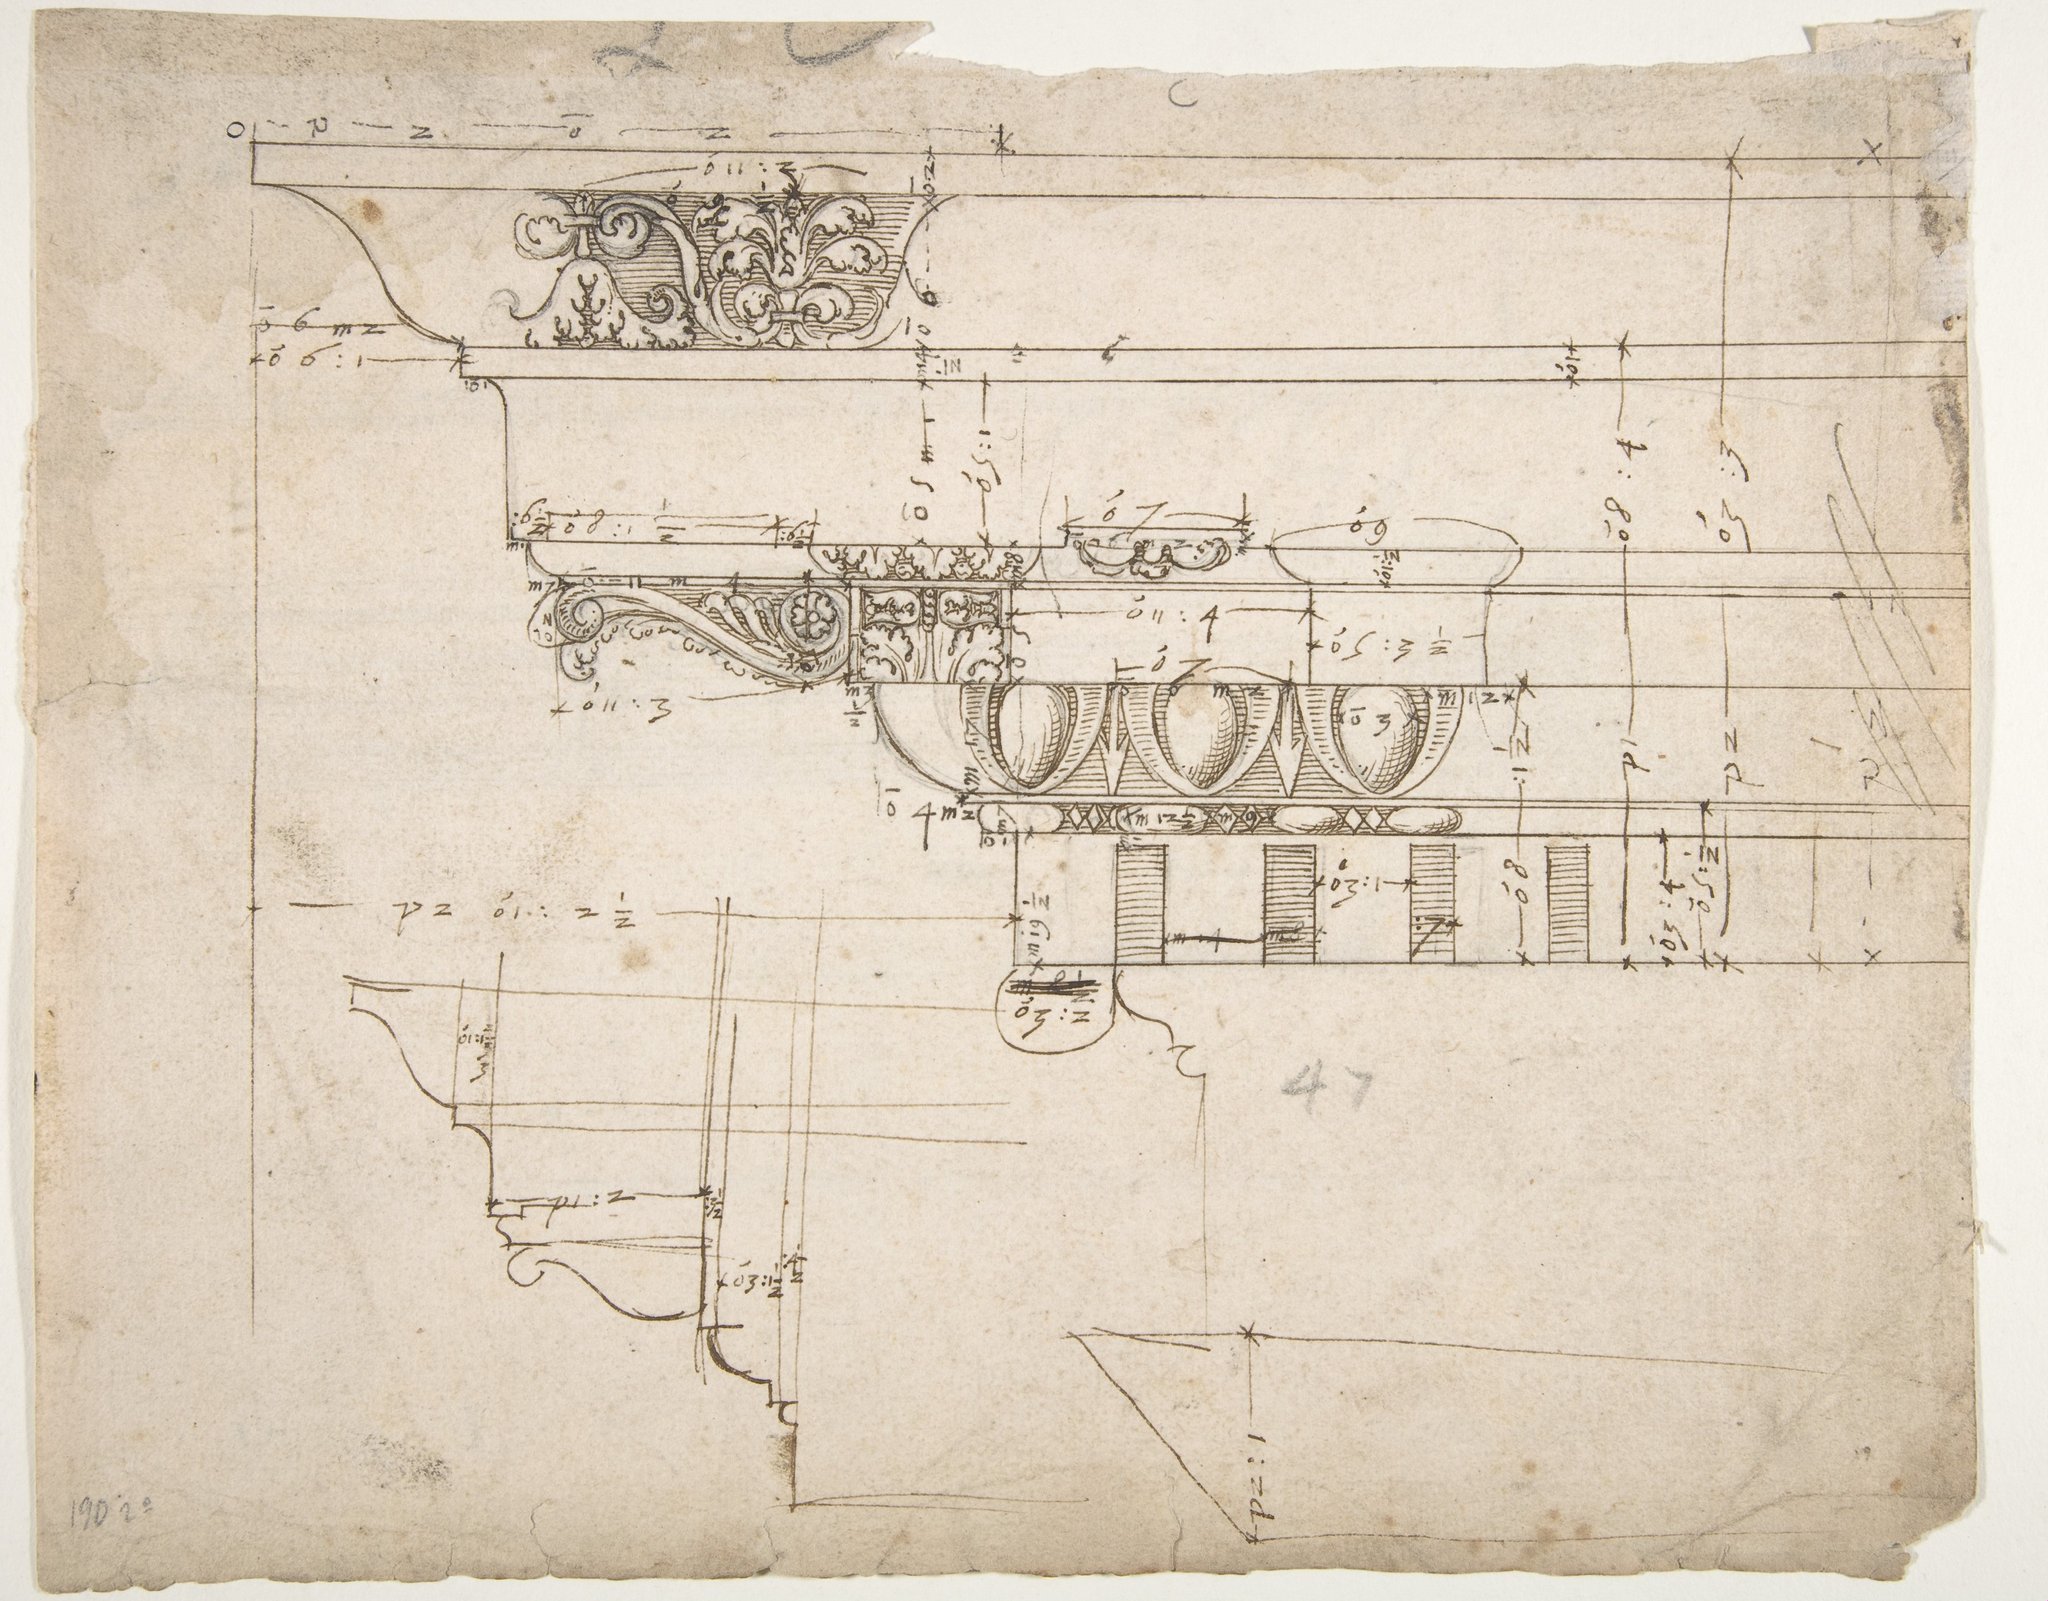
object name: collection ornament architecture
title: Arco dei Pantani, Forum of Augustus, cornice, elevation; schematic elevation (recto) Temple of Apollo Sosiano, column base, elevation (verso)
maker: anonymous, french, 16th century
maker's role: draftsman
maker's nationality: french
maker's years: 1500-1600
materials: chalk, ink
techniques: incising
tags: architecture